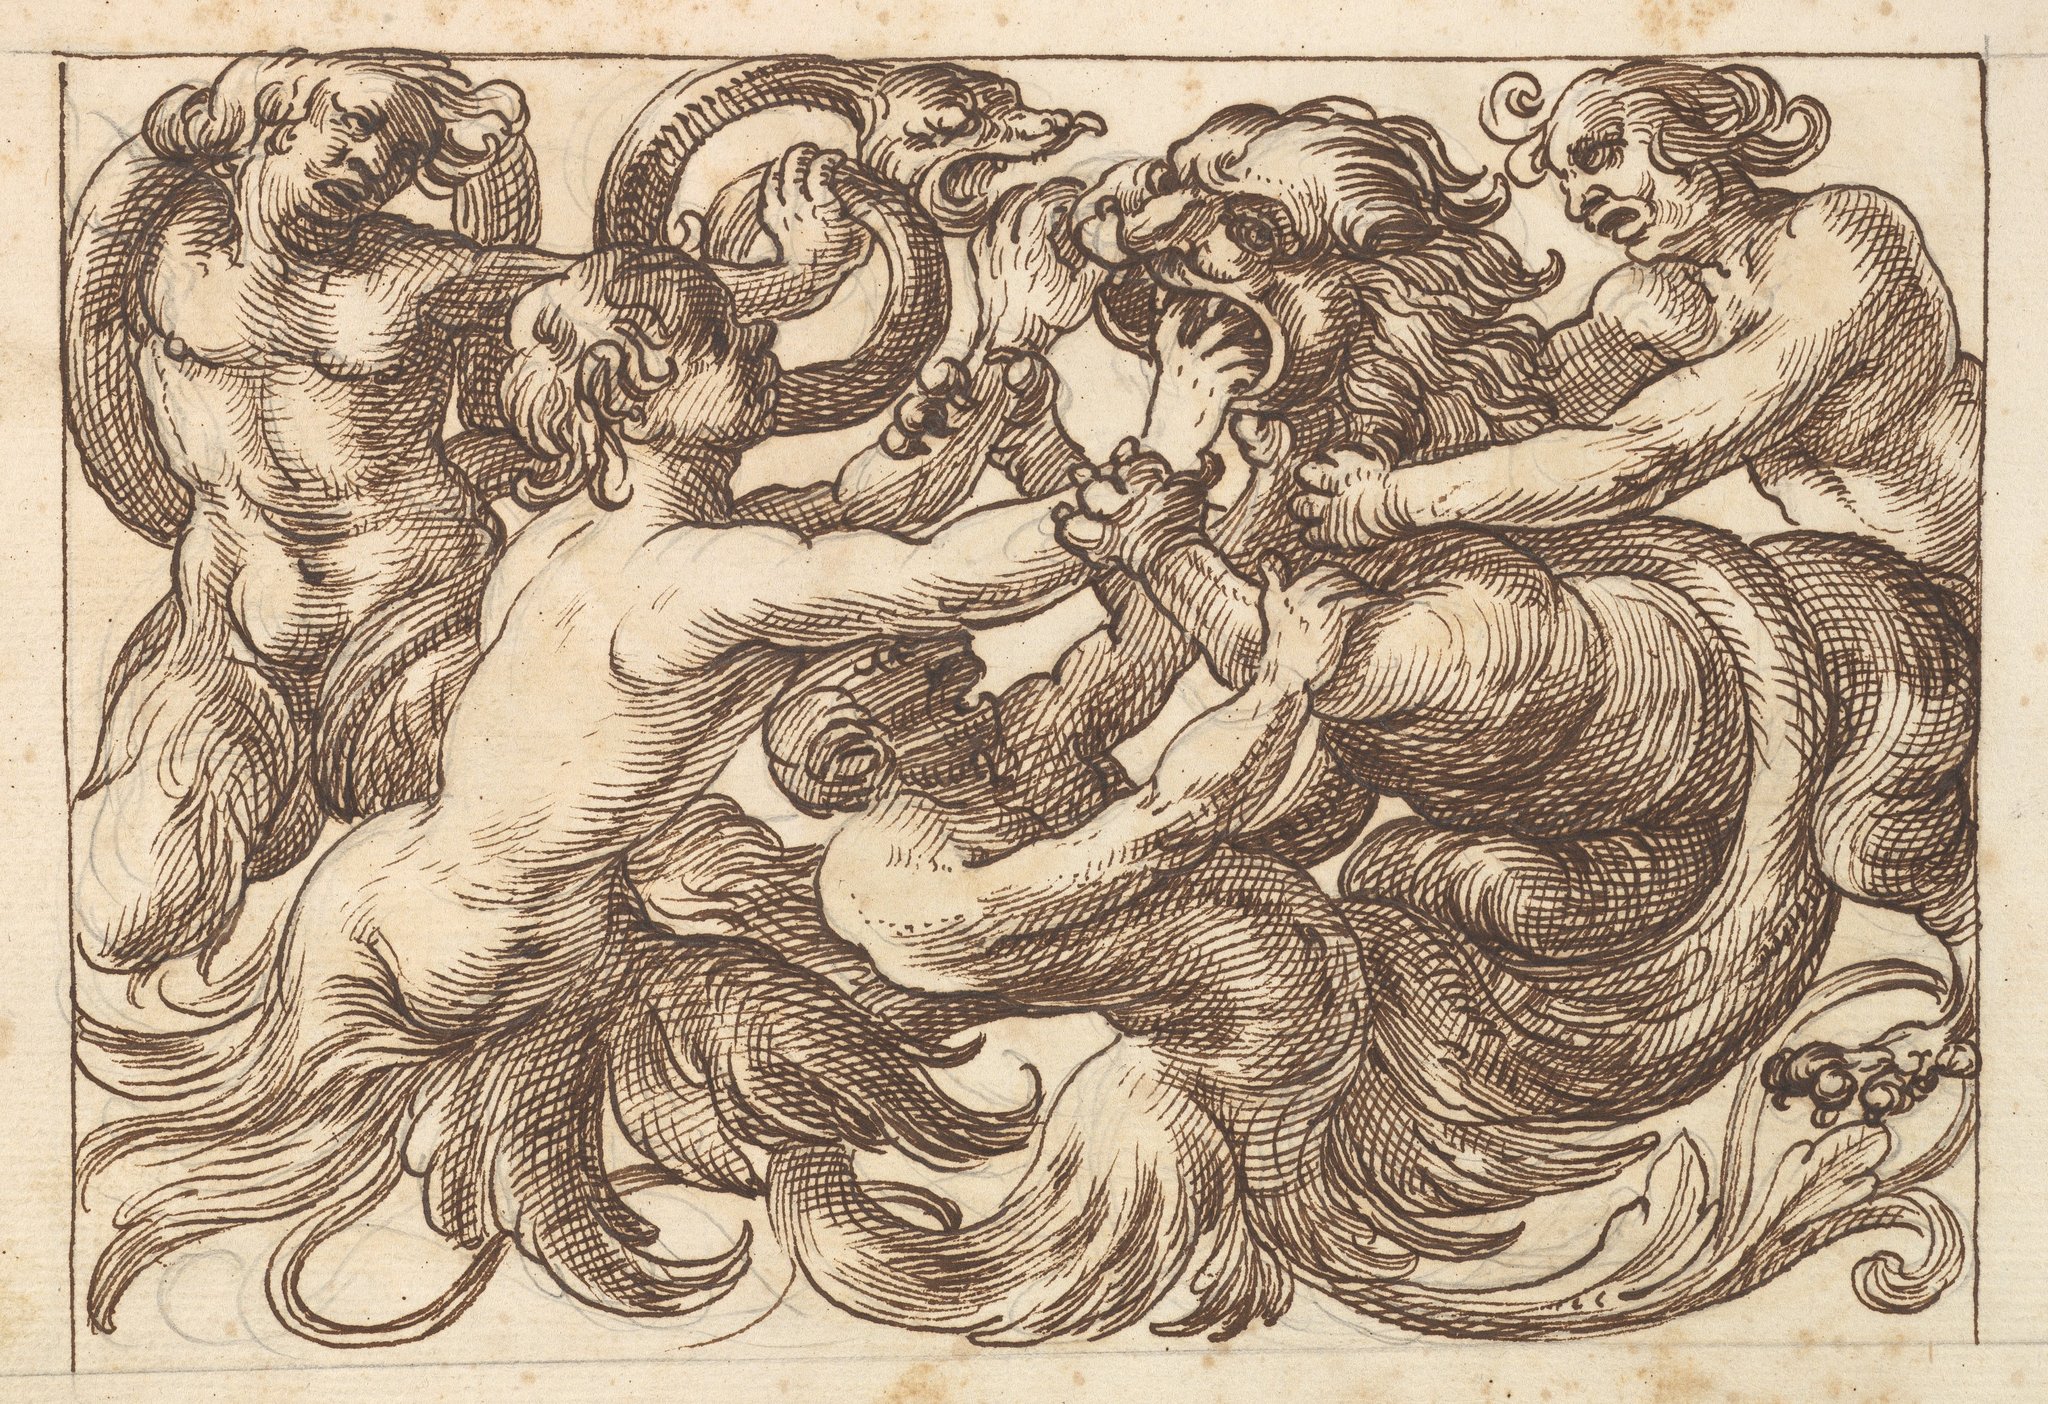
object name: collection ornament architecture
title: Horizontal Panel Design with Four Male Figures Fighting a Lion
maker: anonymous, italian, venetian, 17th century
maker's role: artist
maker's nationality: italian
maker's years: 1600-1700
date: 1601-1700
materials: ink, drawing material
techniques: pen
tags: men,lions,snakes,leaves